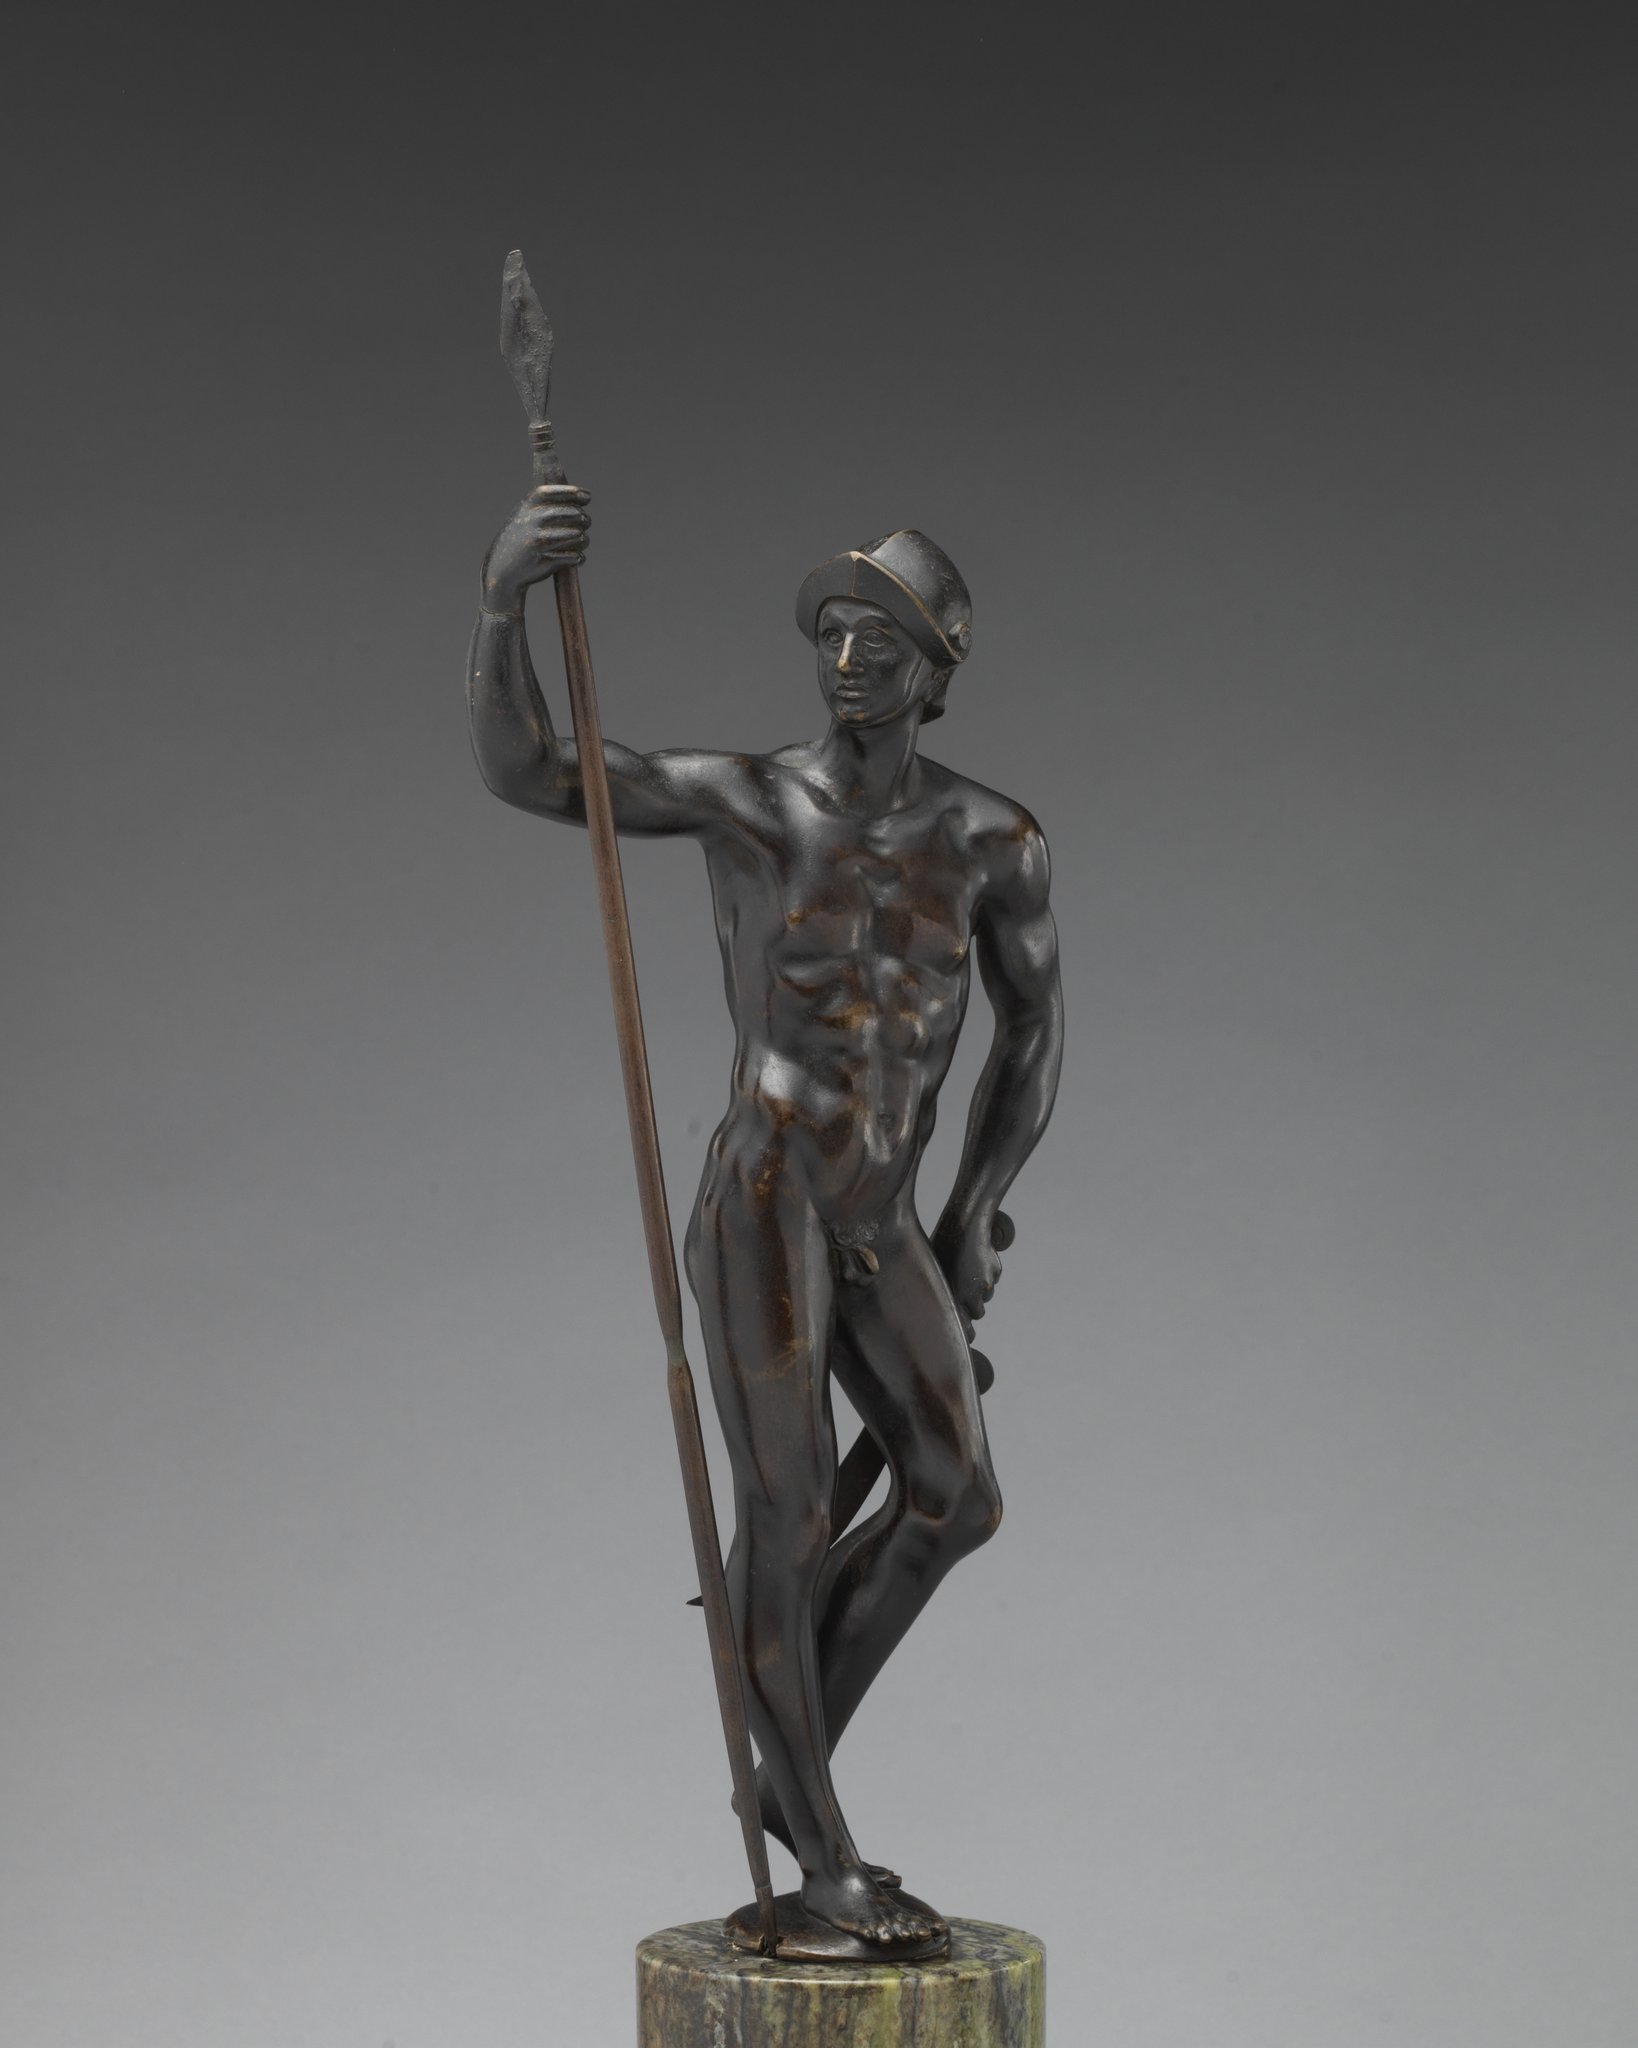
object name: statuette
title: Nude Warrior with Helmet, Spear and Sword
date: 1567-1600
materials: bronze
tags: helmets,spears,swords,male nudes,warriors